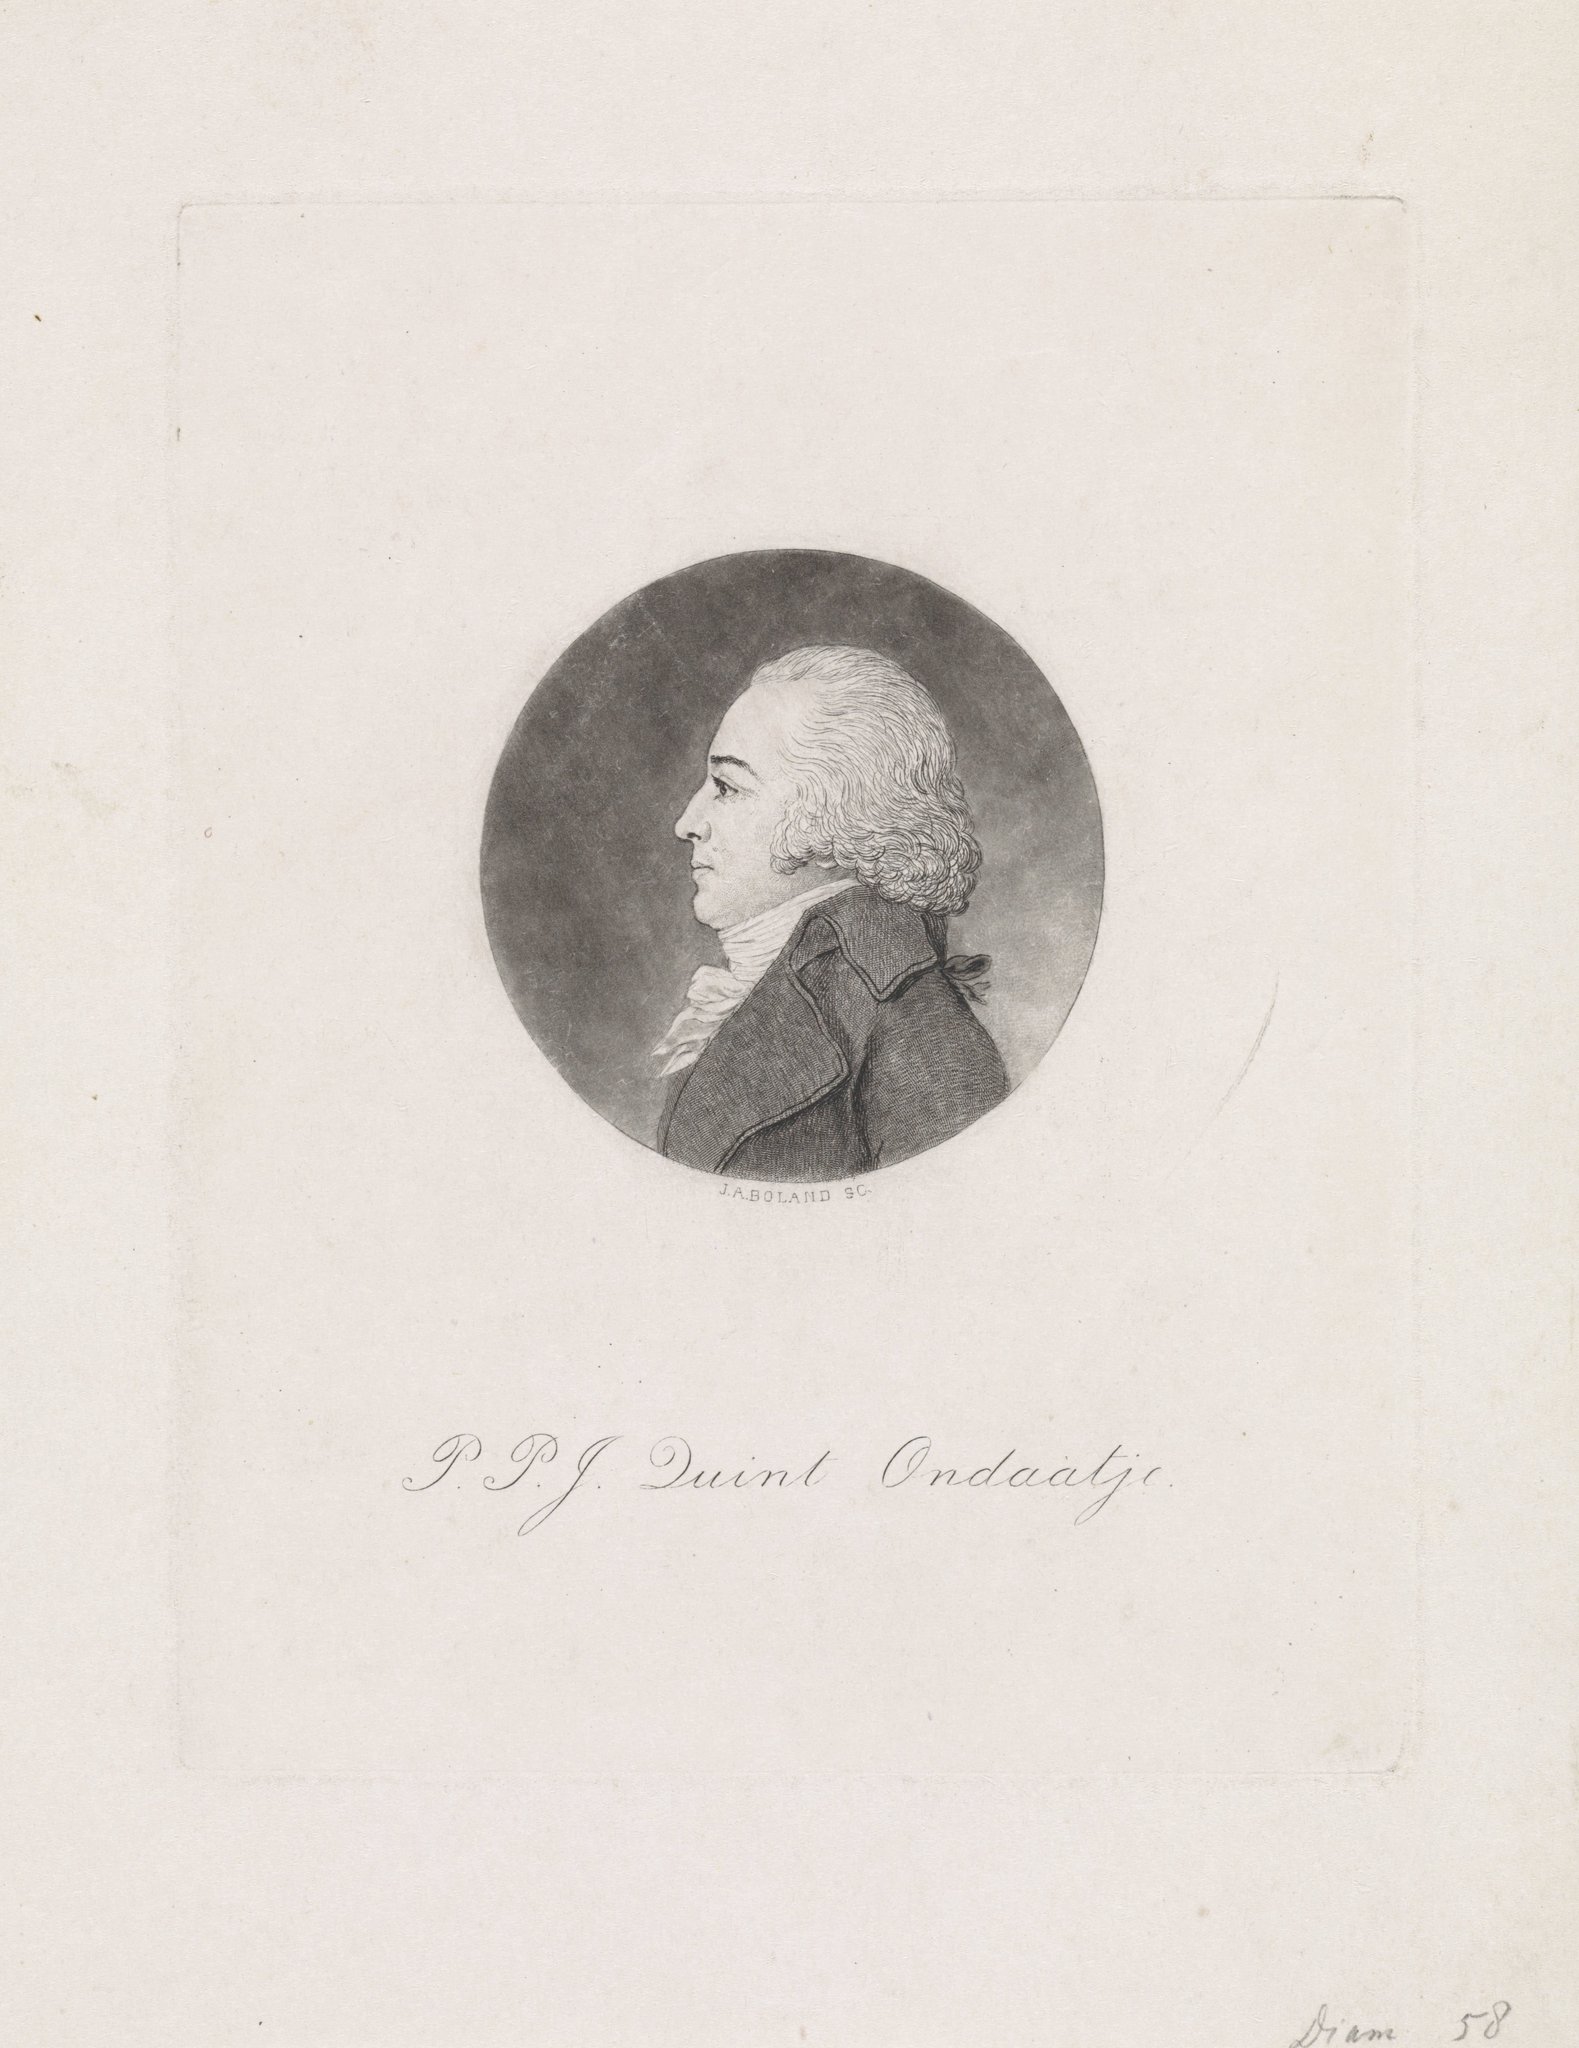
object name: print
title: Portret in profiel van Pieter Philip Juriaan Quint Ondaatje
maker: johannes arnoldus boland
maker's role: print maker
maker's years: 1838-1922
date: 1848-1878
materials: paper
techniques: engraving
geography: netherlands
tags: batavia, pieter philip juriaan quint ondaatje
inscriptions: collector's mark: Lugt 2228, :